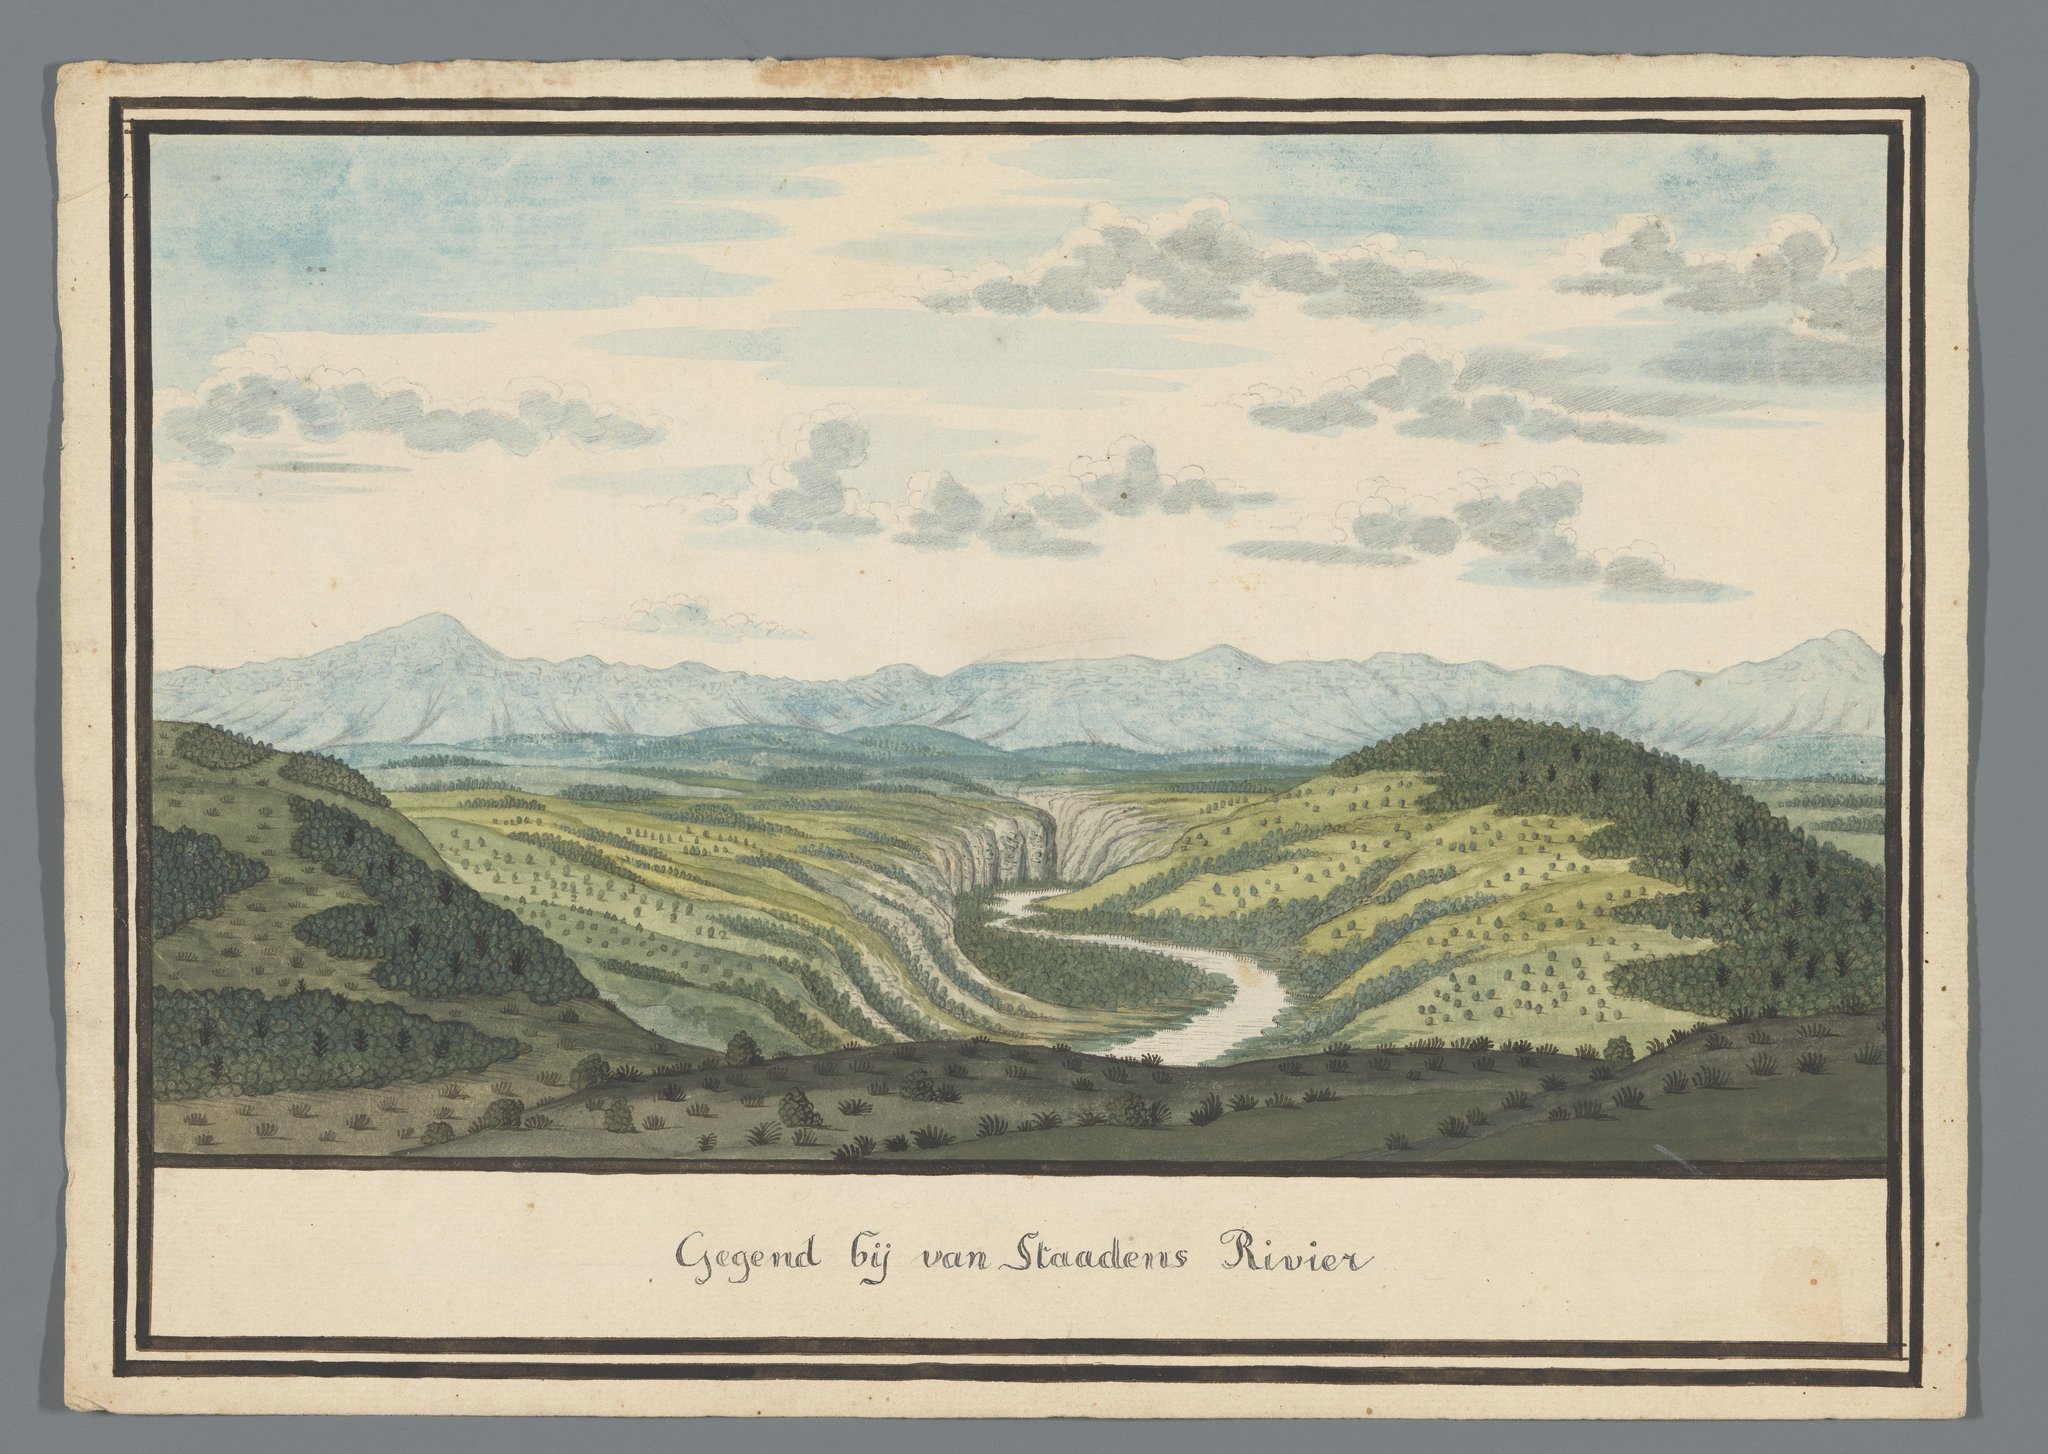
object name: drawing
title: Aquarellen betrekking hebbende op de drie reizen door de Kaap door Hendrik Swellengrebel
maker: johannes schumacher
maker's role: draughtsman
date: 1711-1776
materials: paper, watercolor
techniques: brush, pen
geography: south africa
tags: river, mountains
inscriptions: label: ‘15’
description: De loop van de Van Stadensrivier door een kloof. Tekening gemaakt tijdens de tweede reis van Hendrik Swellengrebel, naar het noordoosten van de Kaapkolonie, 10 september - 26 december 1776. Volgens het reisjournaal bivakkeert het gezelschap op 18-19 november 1776 bij de rivier.